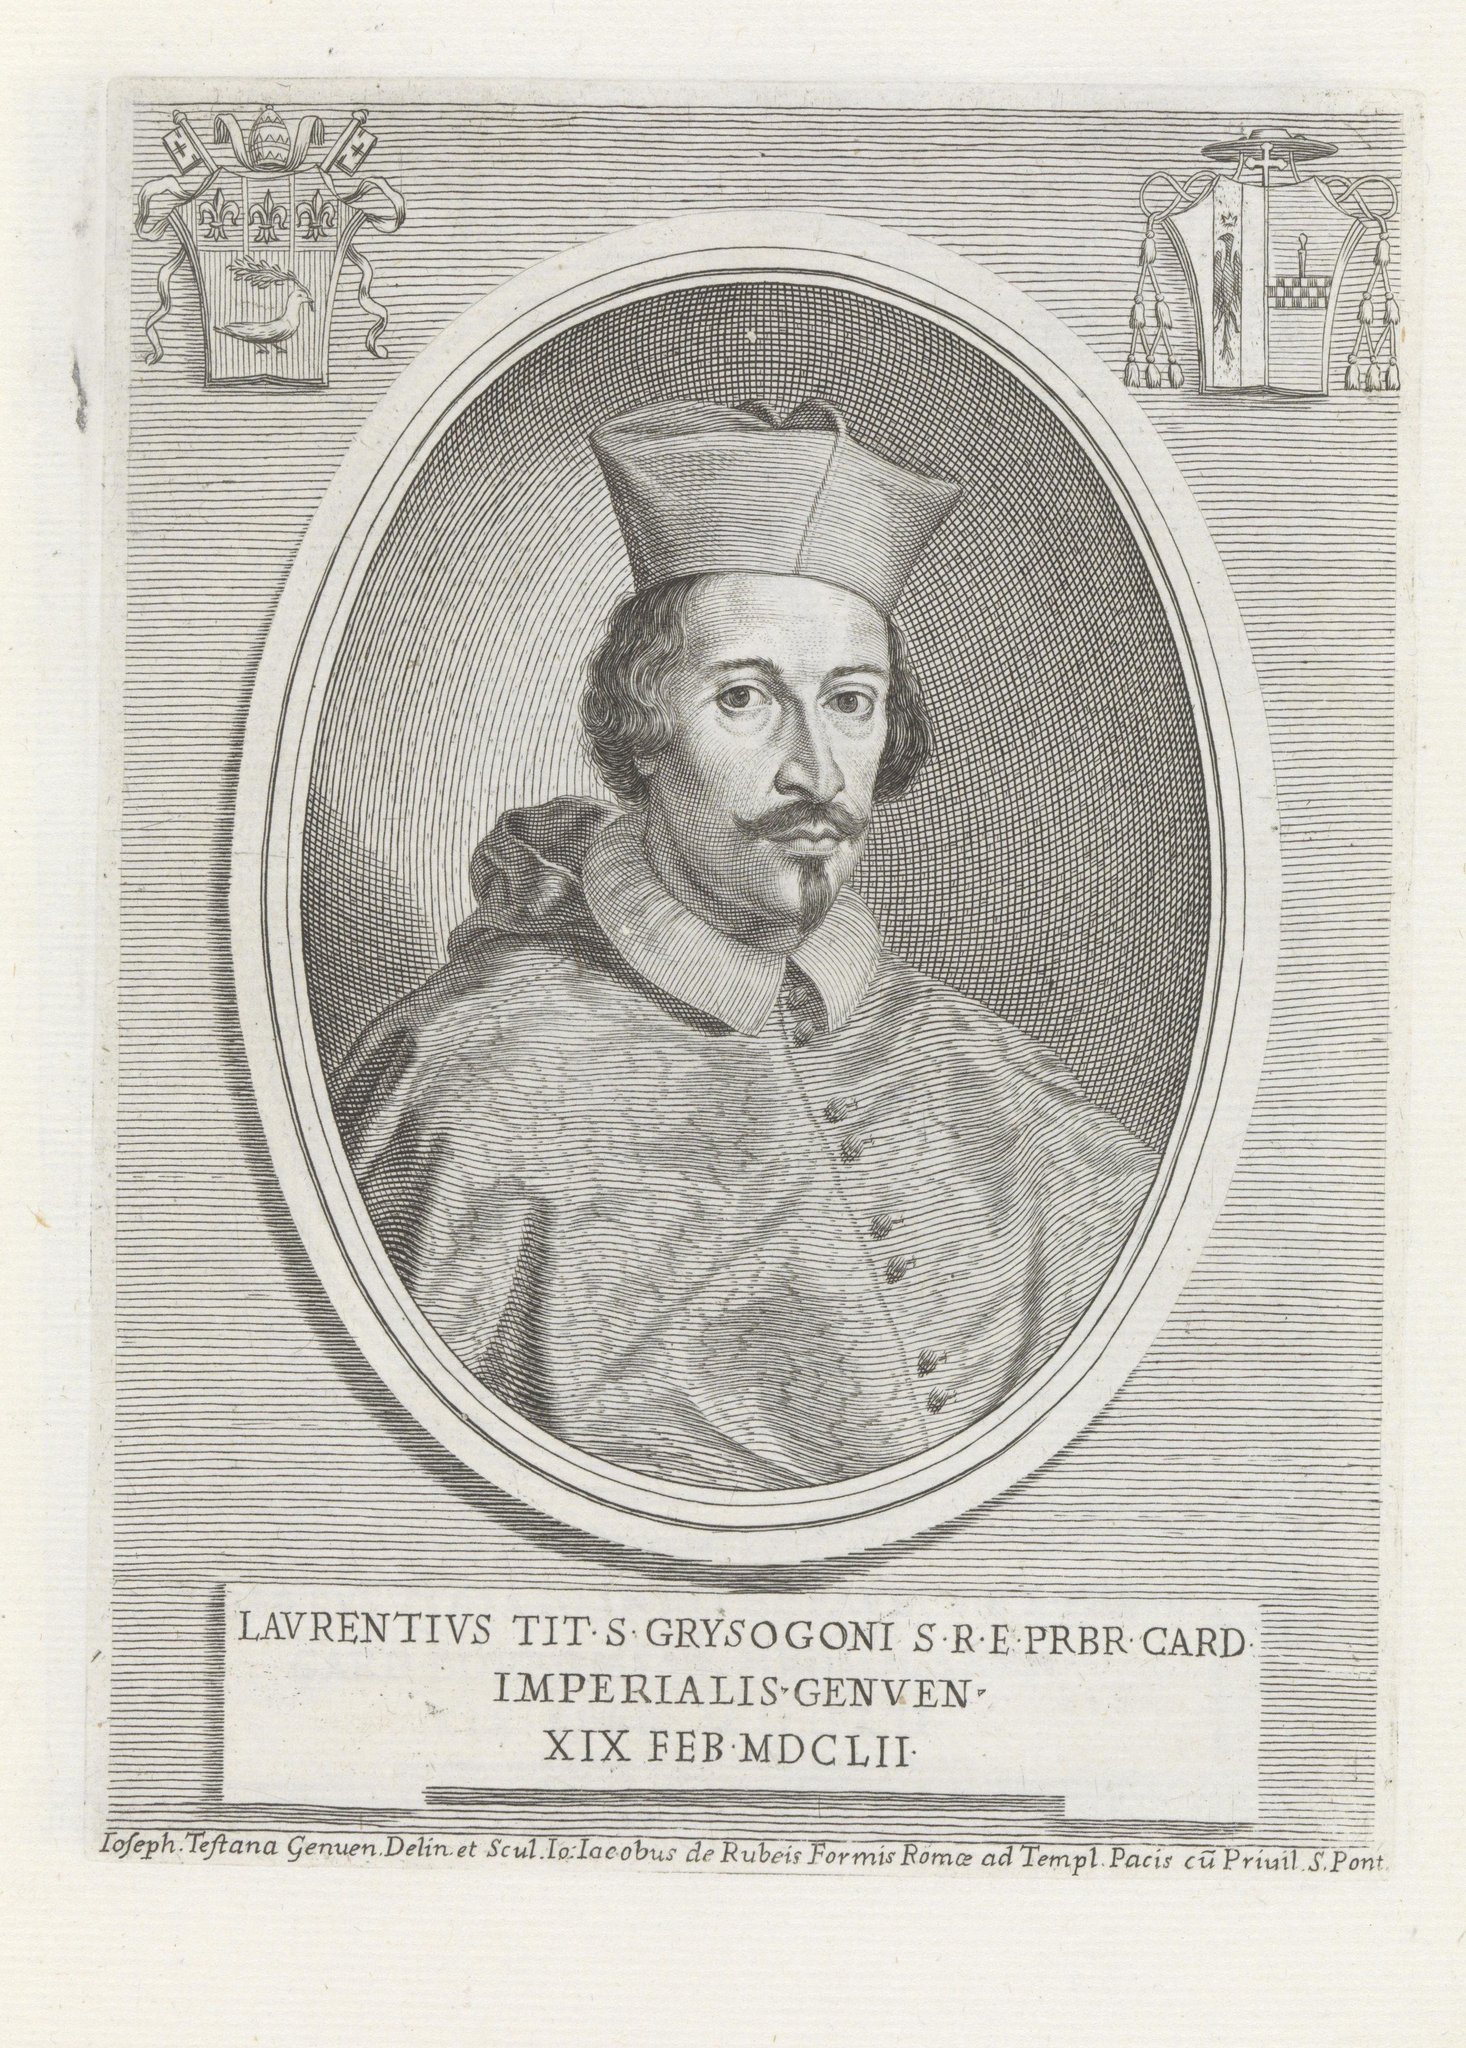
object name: print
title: Portret van kardinaal Lorenzo Imperiali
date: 1658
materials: paper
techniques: engraving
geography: rome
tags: rome, cardinal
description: Portret van kardinaal Lorenzo Imperiali. Linksboven het wapen van paus Innocentius X en rechtsboven het wapen van de kardinaal. Onderaan een onderschrift in het Latijn. De prent maakt deel uit van een album.